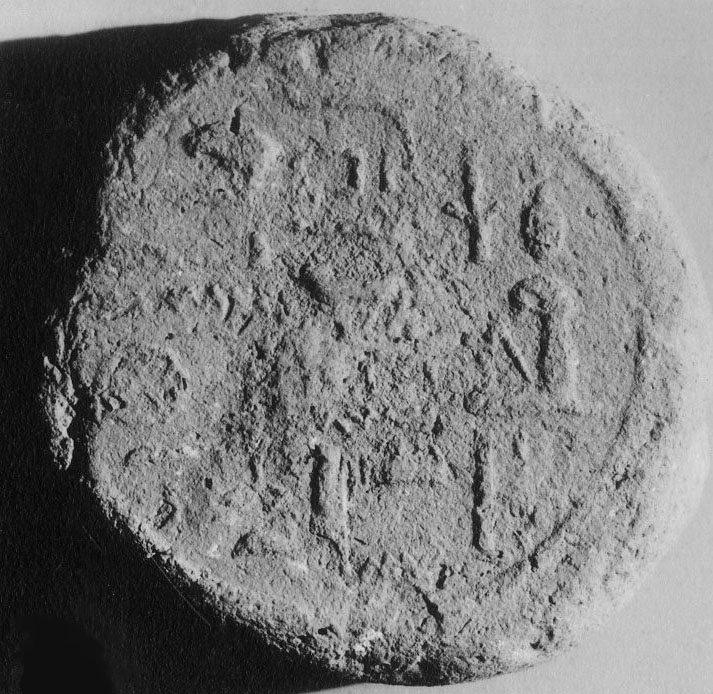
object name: cone, circular impression, sennefer, mayor, overseer, steward, amun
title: Funerary Cone the Steward of Amun Sennefer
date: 1479-1400 BCE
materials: pottery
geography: egypt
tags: hieroglyphs